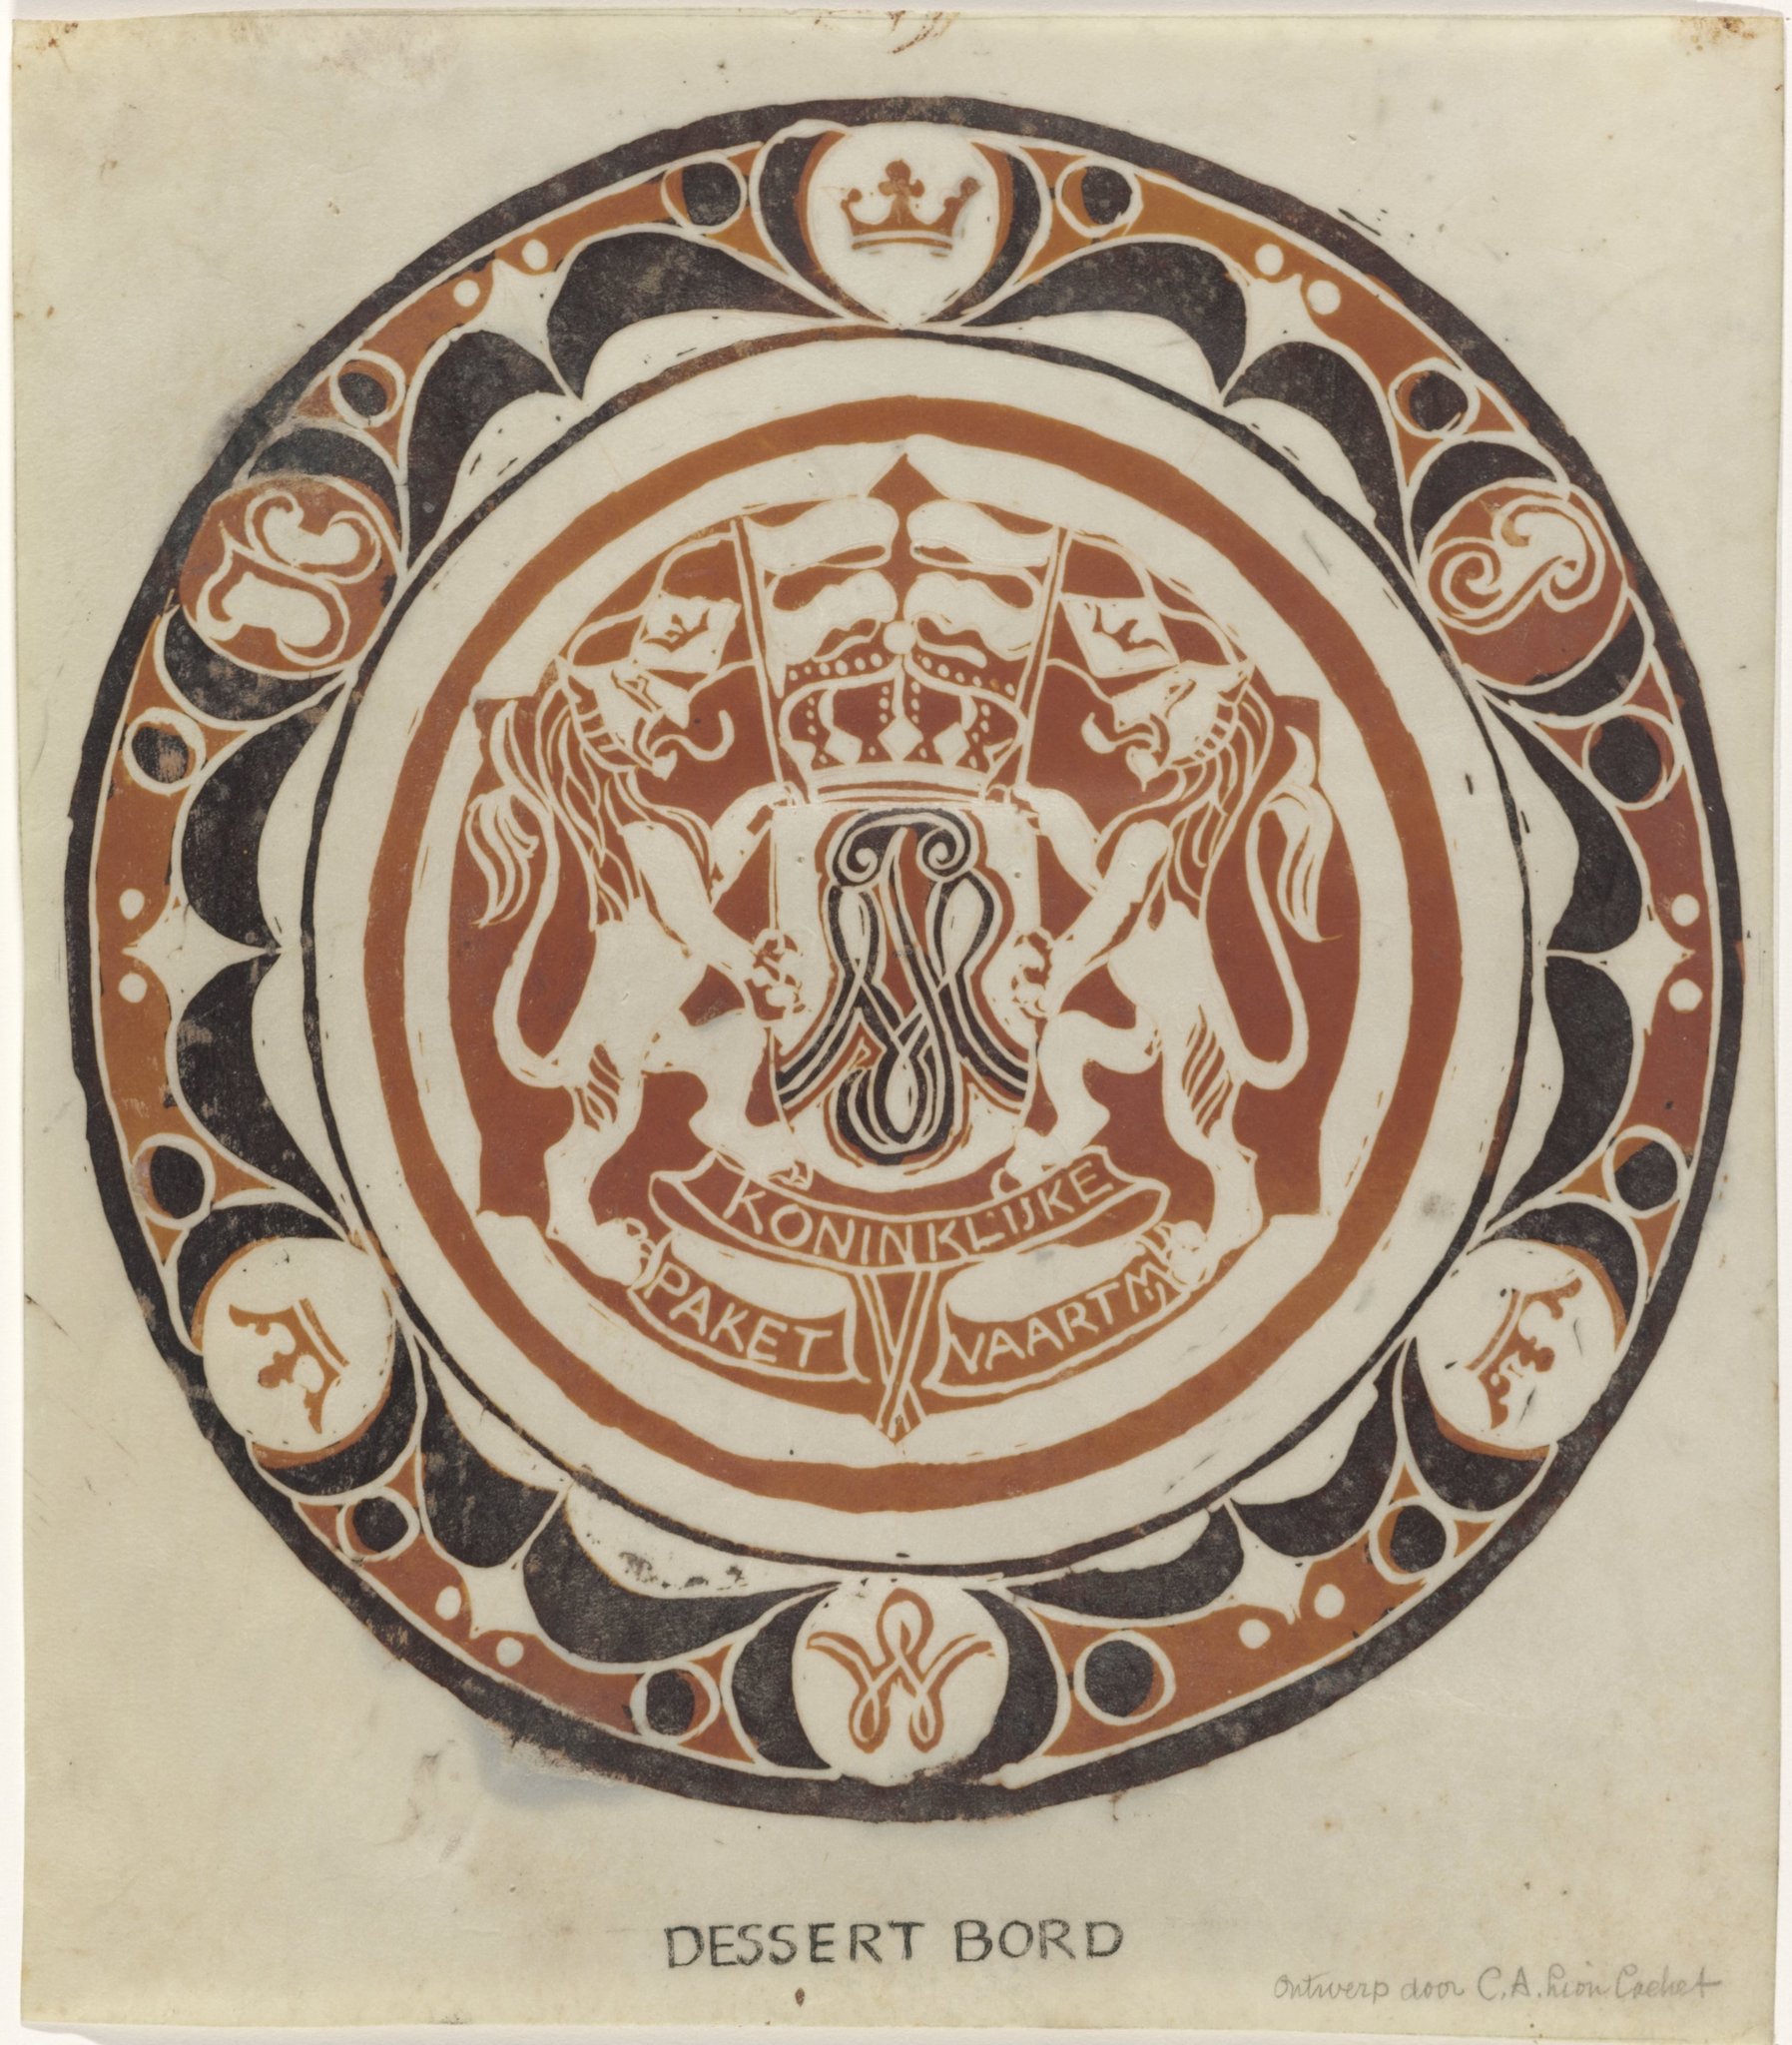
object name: print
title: Ontwerp voor gedenkbord van de Koninklijke Paketvaart Maatschappij bij de geboorte van prinses Juliana in 1909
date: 1909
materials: parchment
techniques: woodcut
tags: the hague, juliana of the netherlands, public festivities at birth of royal persons, dish, plate, saucer